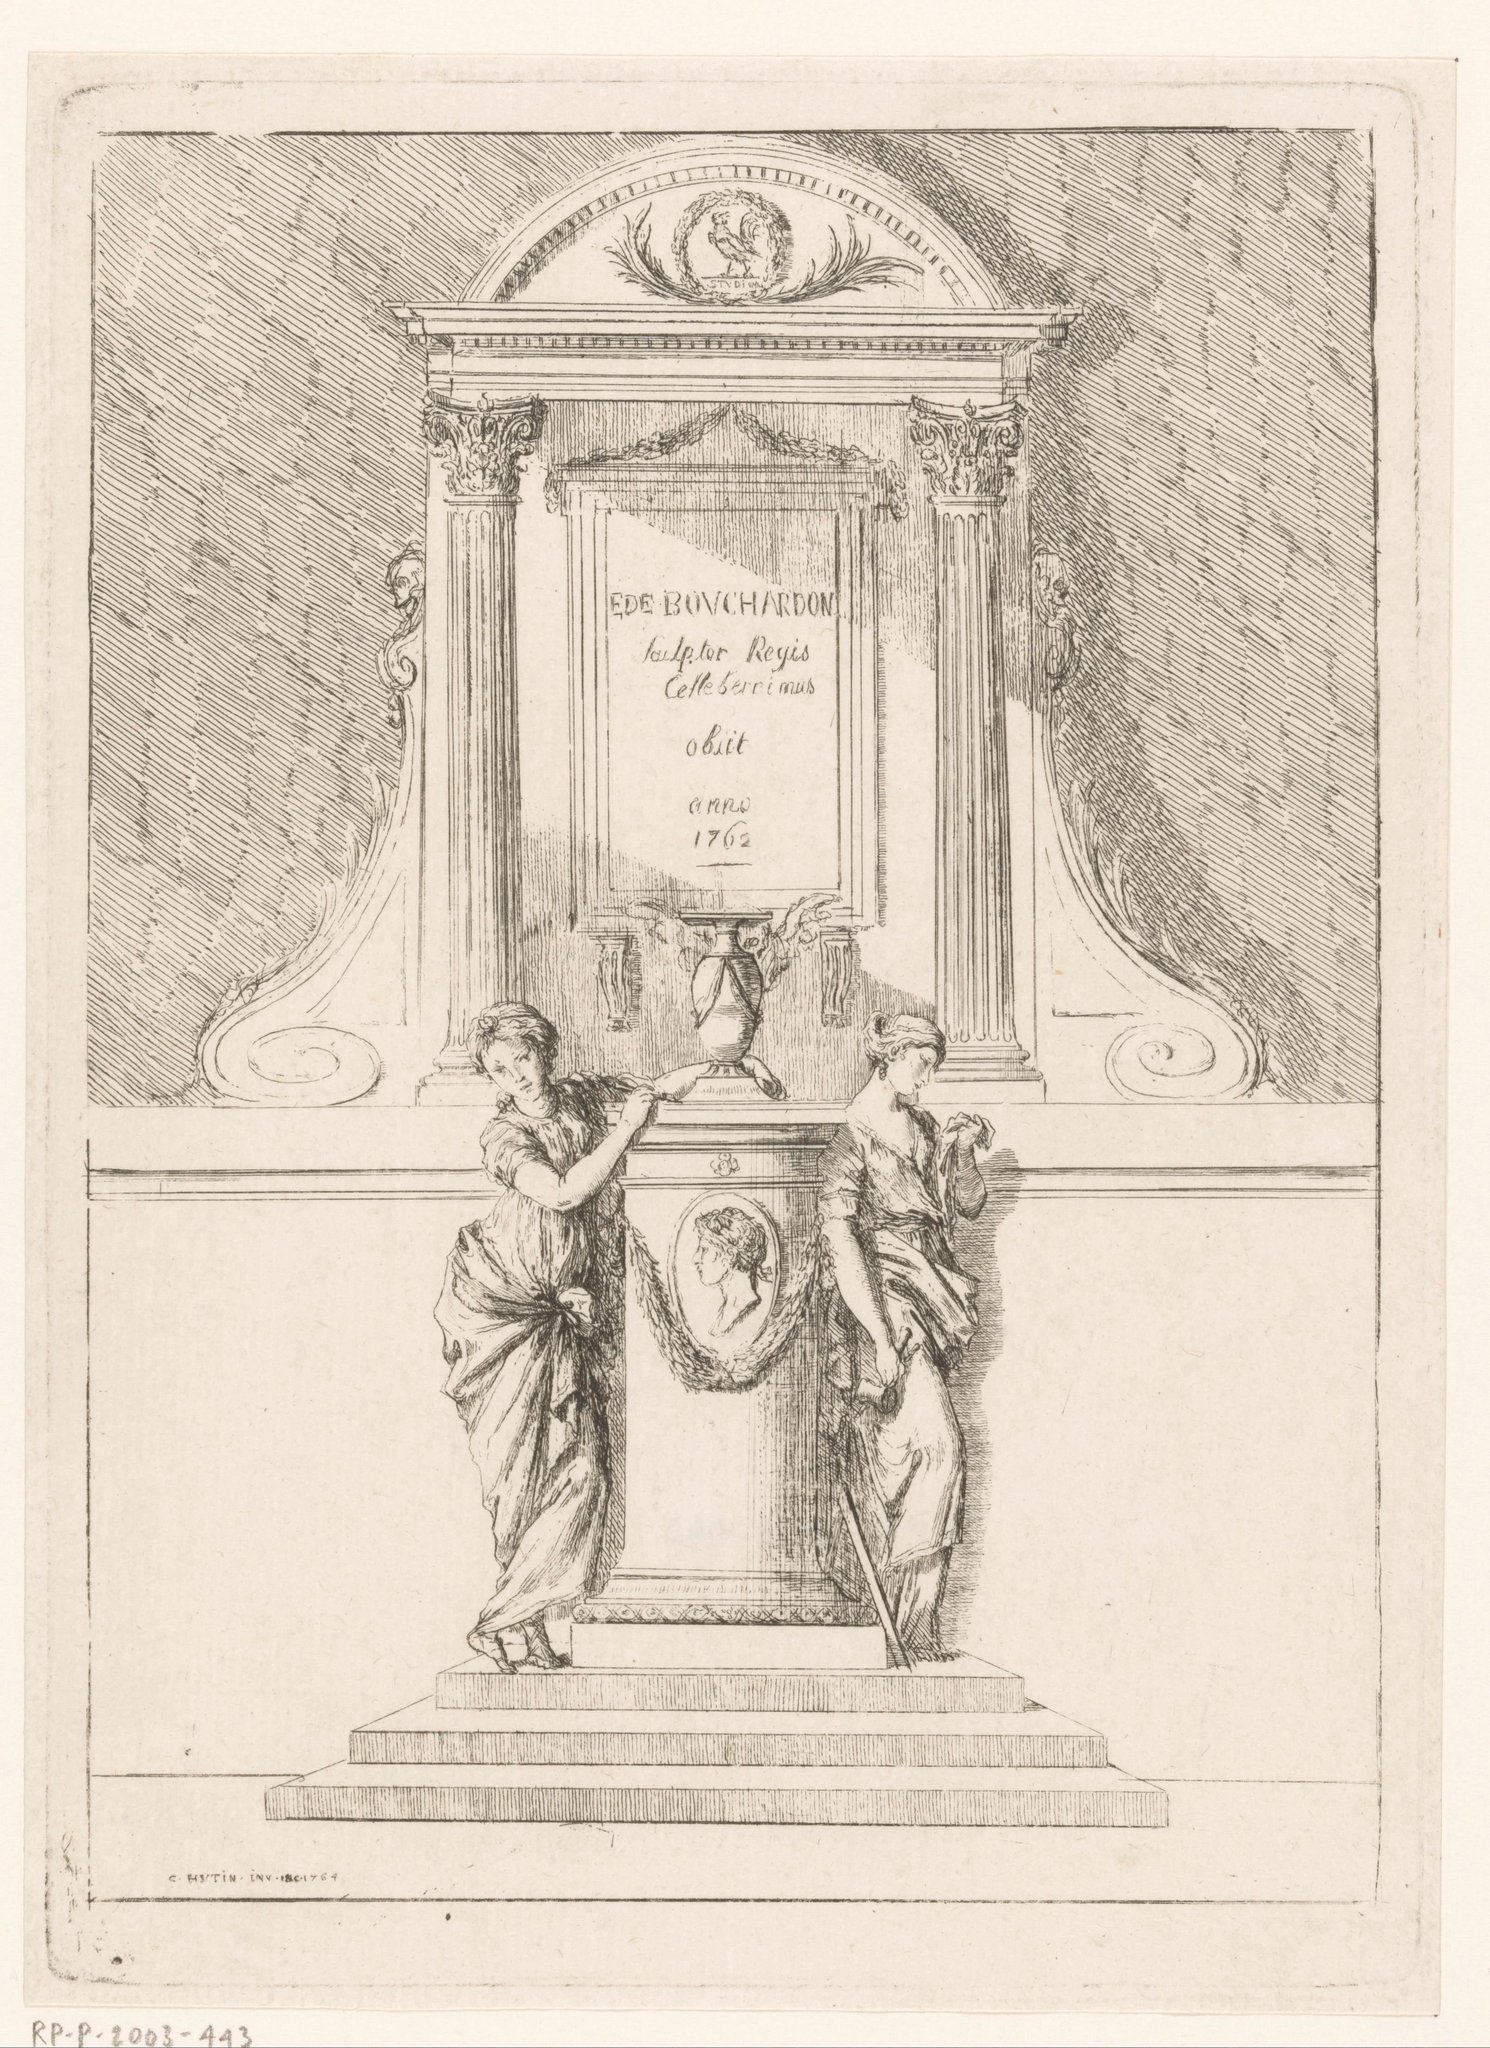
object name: ornament print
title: Grafmonumenten voor kunstenaars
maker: charles françois hutin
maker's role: draughtsman, print maker, sculptor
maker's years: 1715-1776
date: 1764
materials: paper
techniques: etching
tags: grave, tomb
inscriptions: collector's mark: Lugt 2228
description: Grafmonument voor de kunstenaar Edmé Bouchardon. Zijn naam staat op de grafsteen, gevat in een omlijsting met Corintische zuilen. Aan de voet ervan staan twee vrouwen aan weerszijden van een zuil.